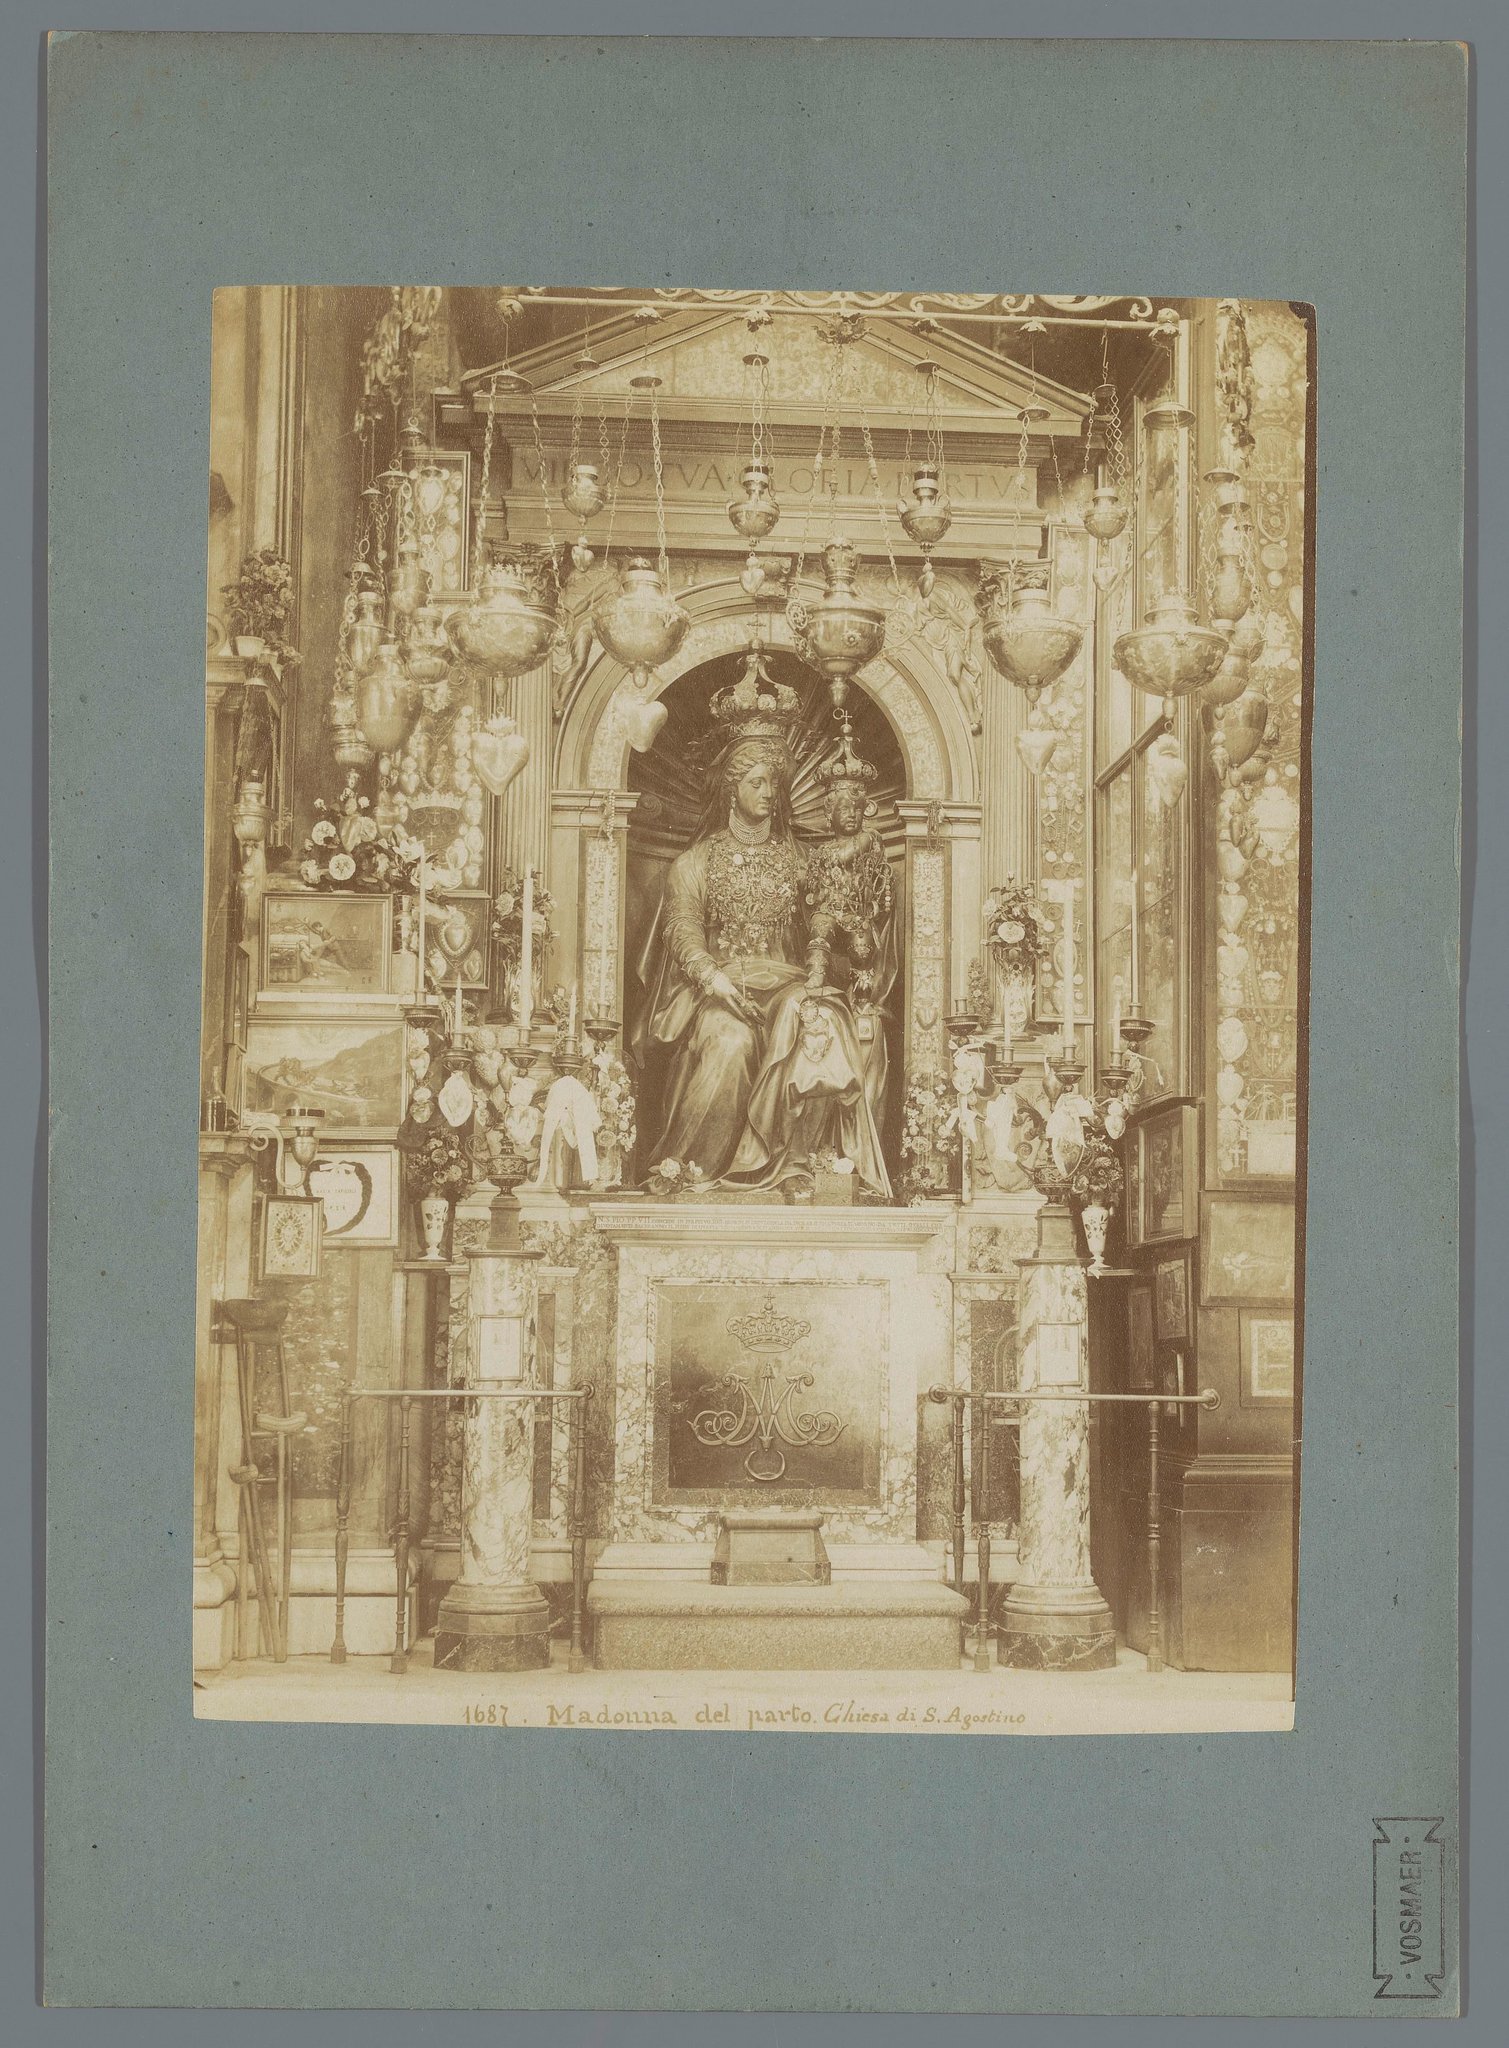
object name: photograph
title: Madonna del parto. Chiesa di S. Agostino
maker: Anonymous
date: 1851-1900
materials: cardboard, paper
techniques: albumen print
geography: rome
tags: piece of sculpture, reproduction of a piece of sculpture, altar with altar-piece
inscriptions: inscription: ‘double’, collector's mark: ‘VOSMAER’, number: ‘1687.’